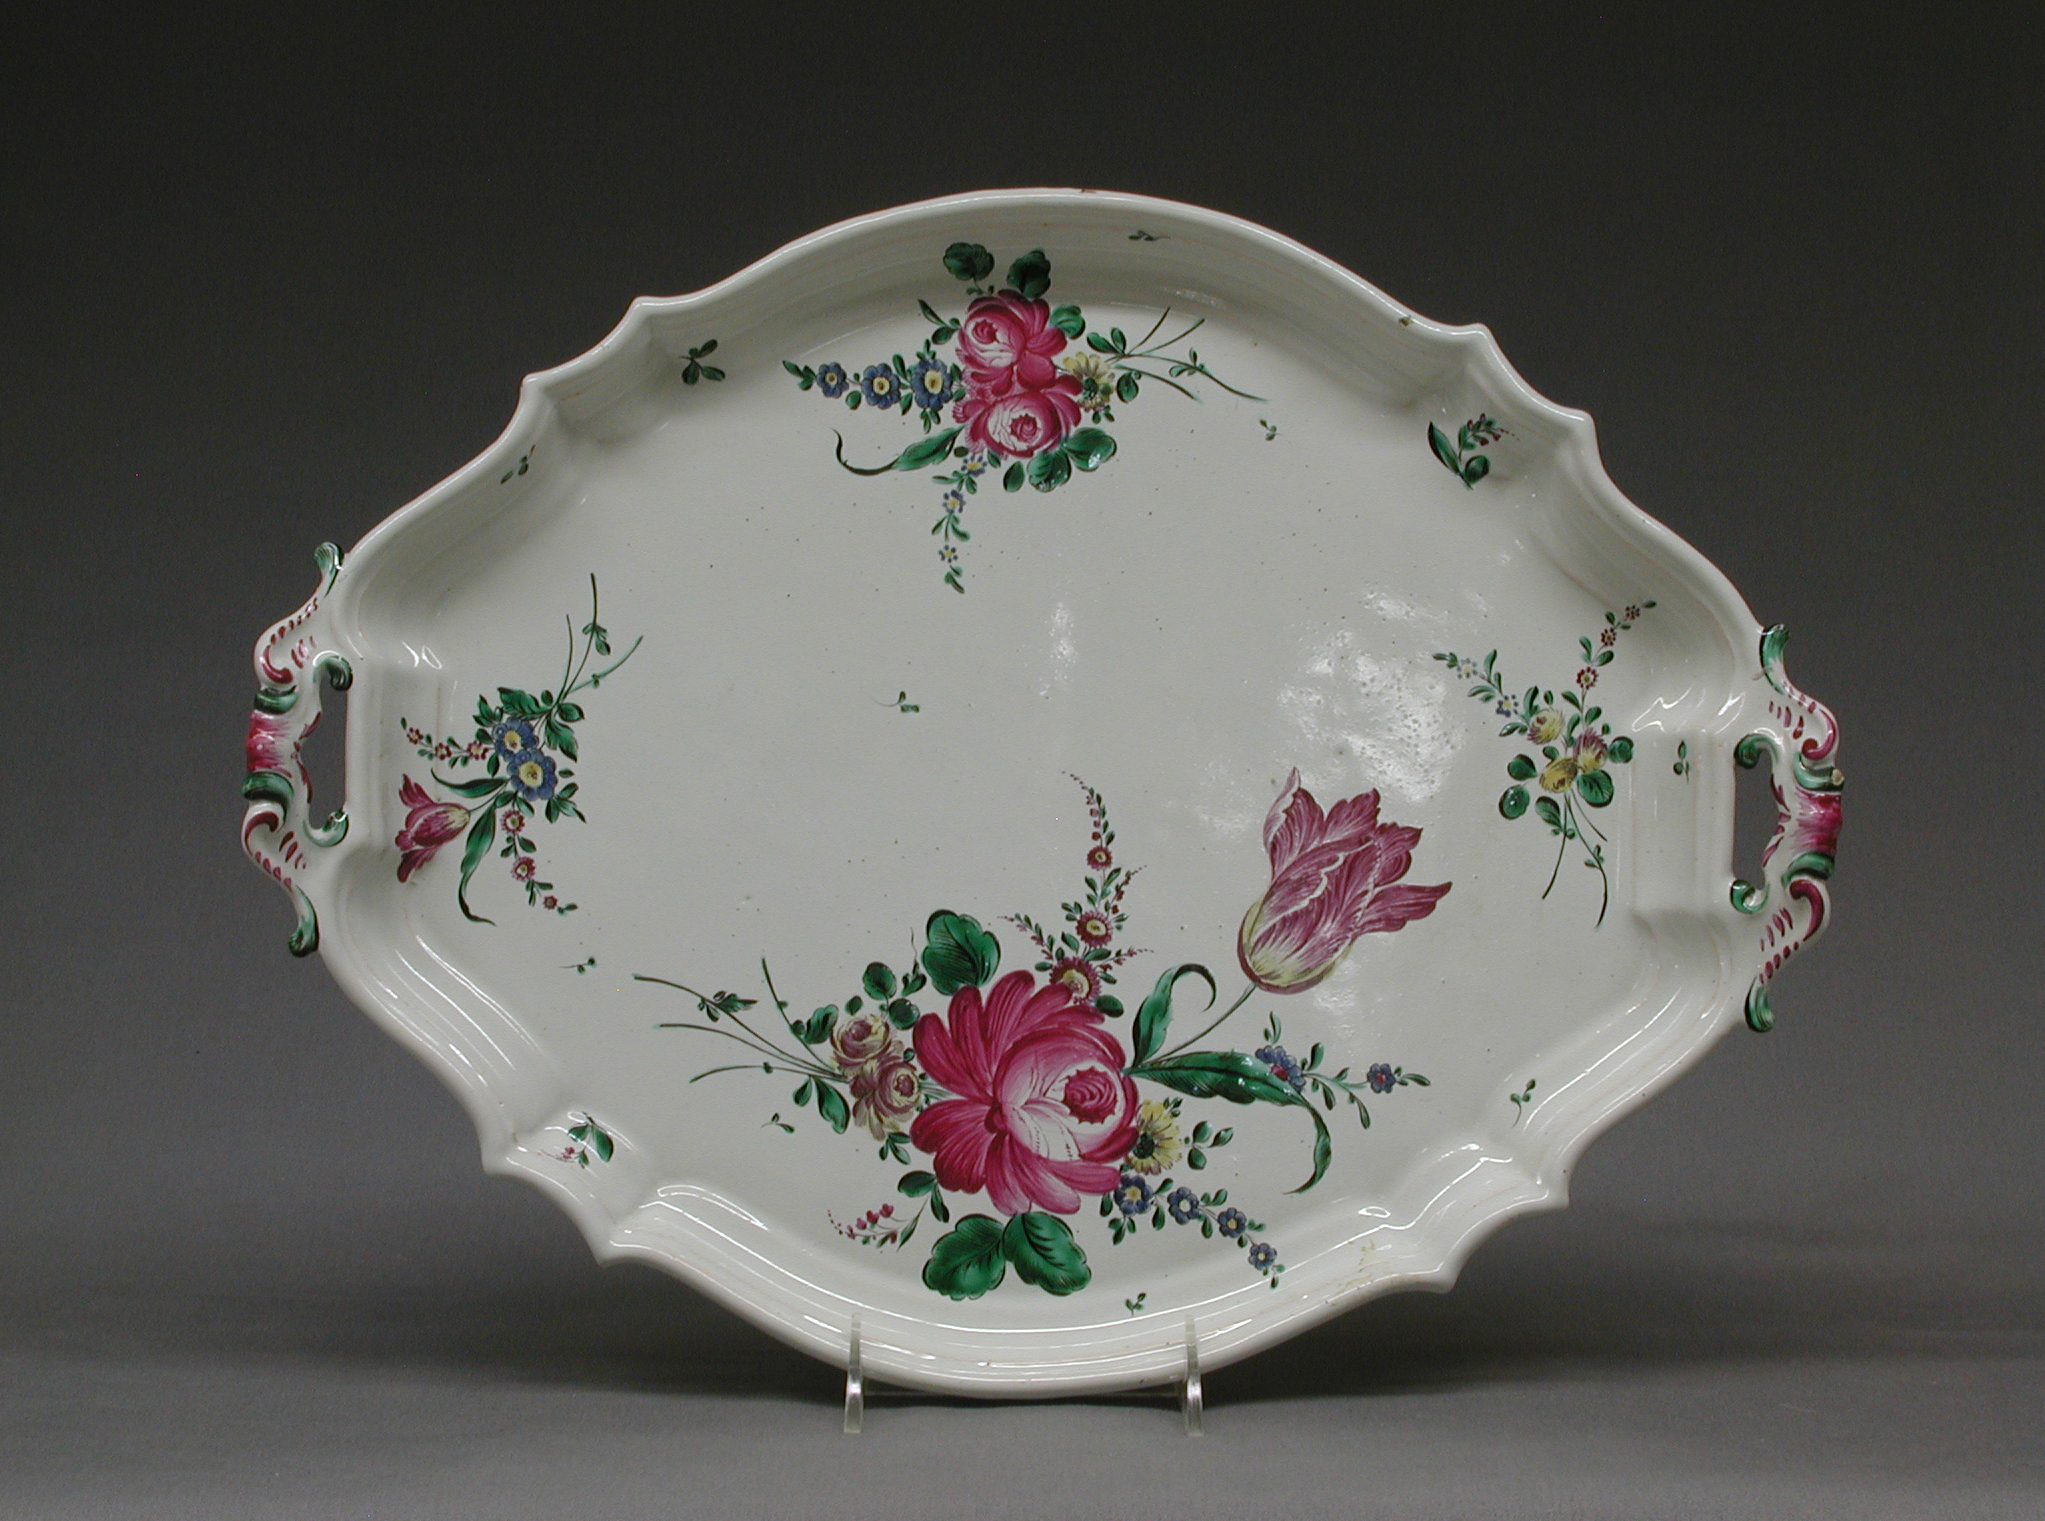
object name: platter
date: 1750-1775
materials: faience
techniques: glazing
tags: flowers